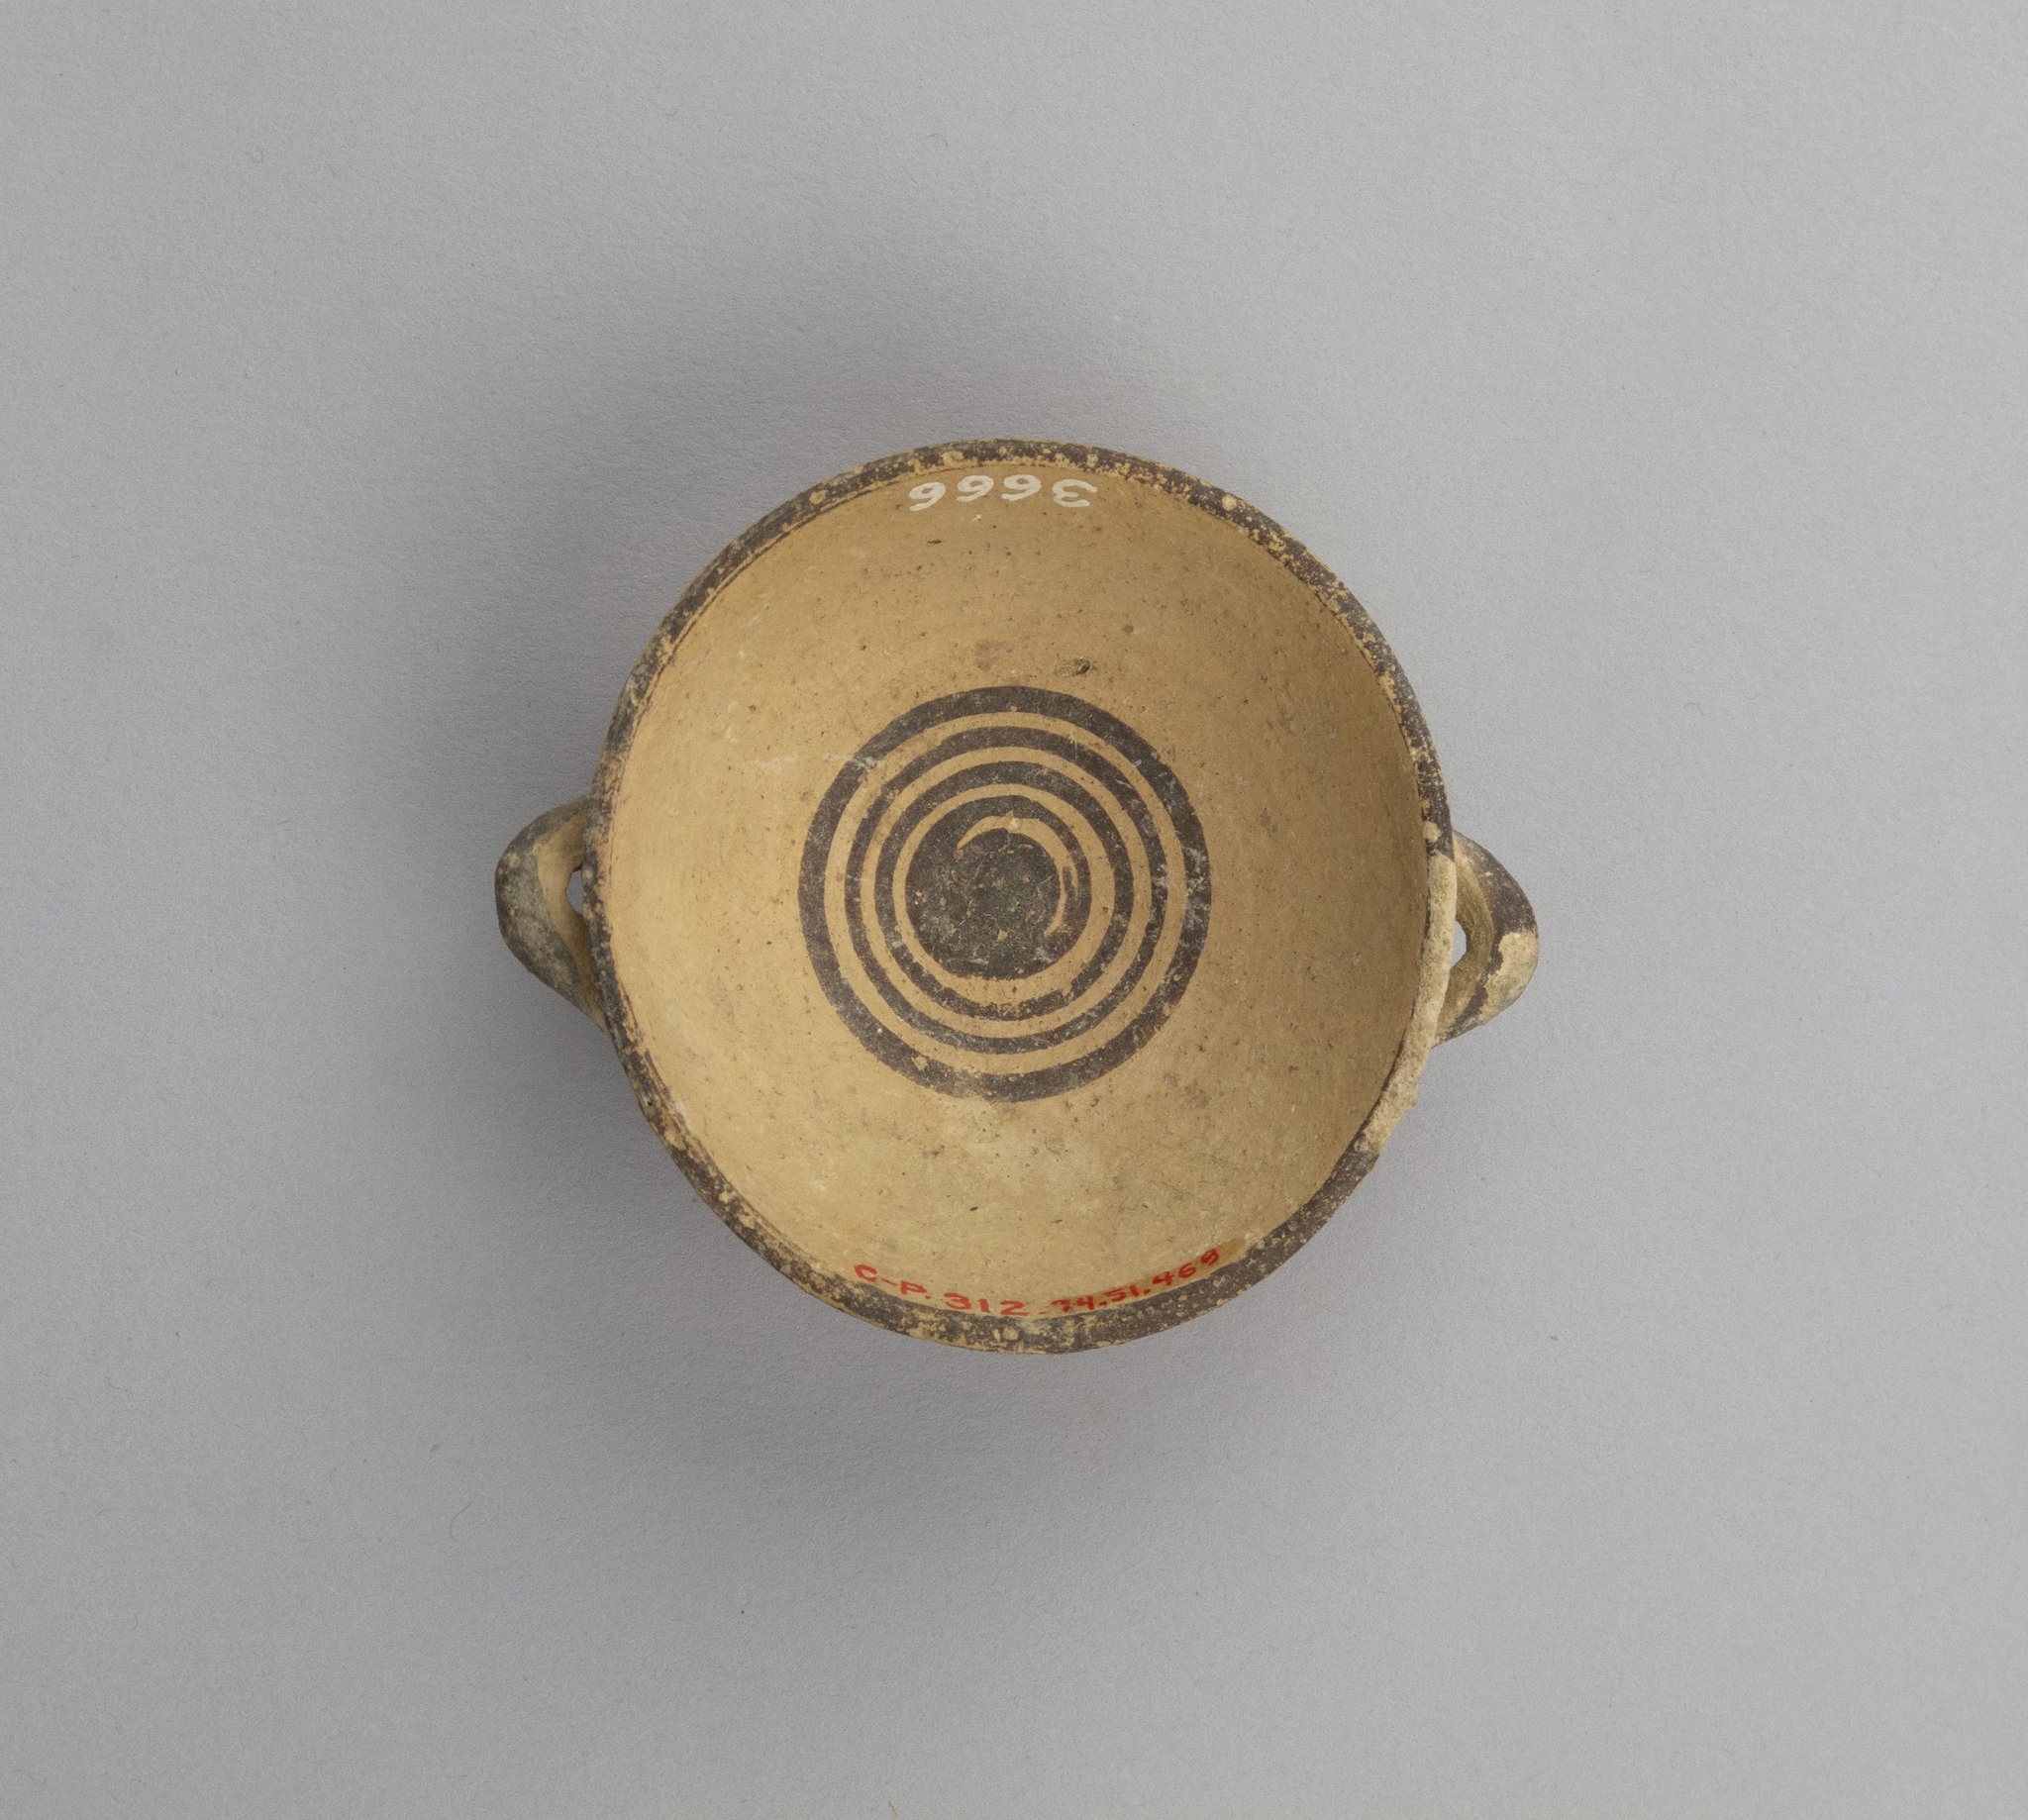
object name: juglet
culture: cypriot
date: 600-480 BCE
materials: terracotta